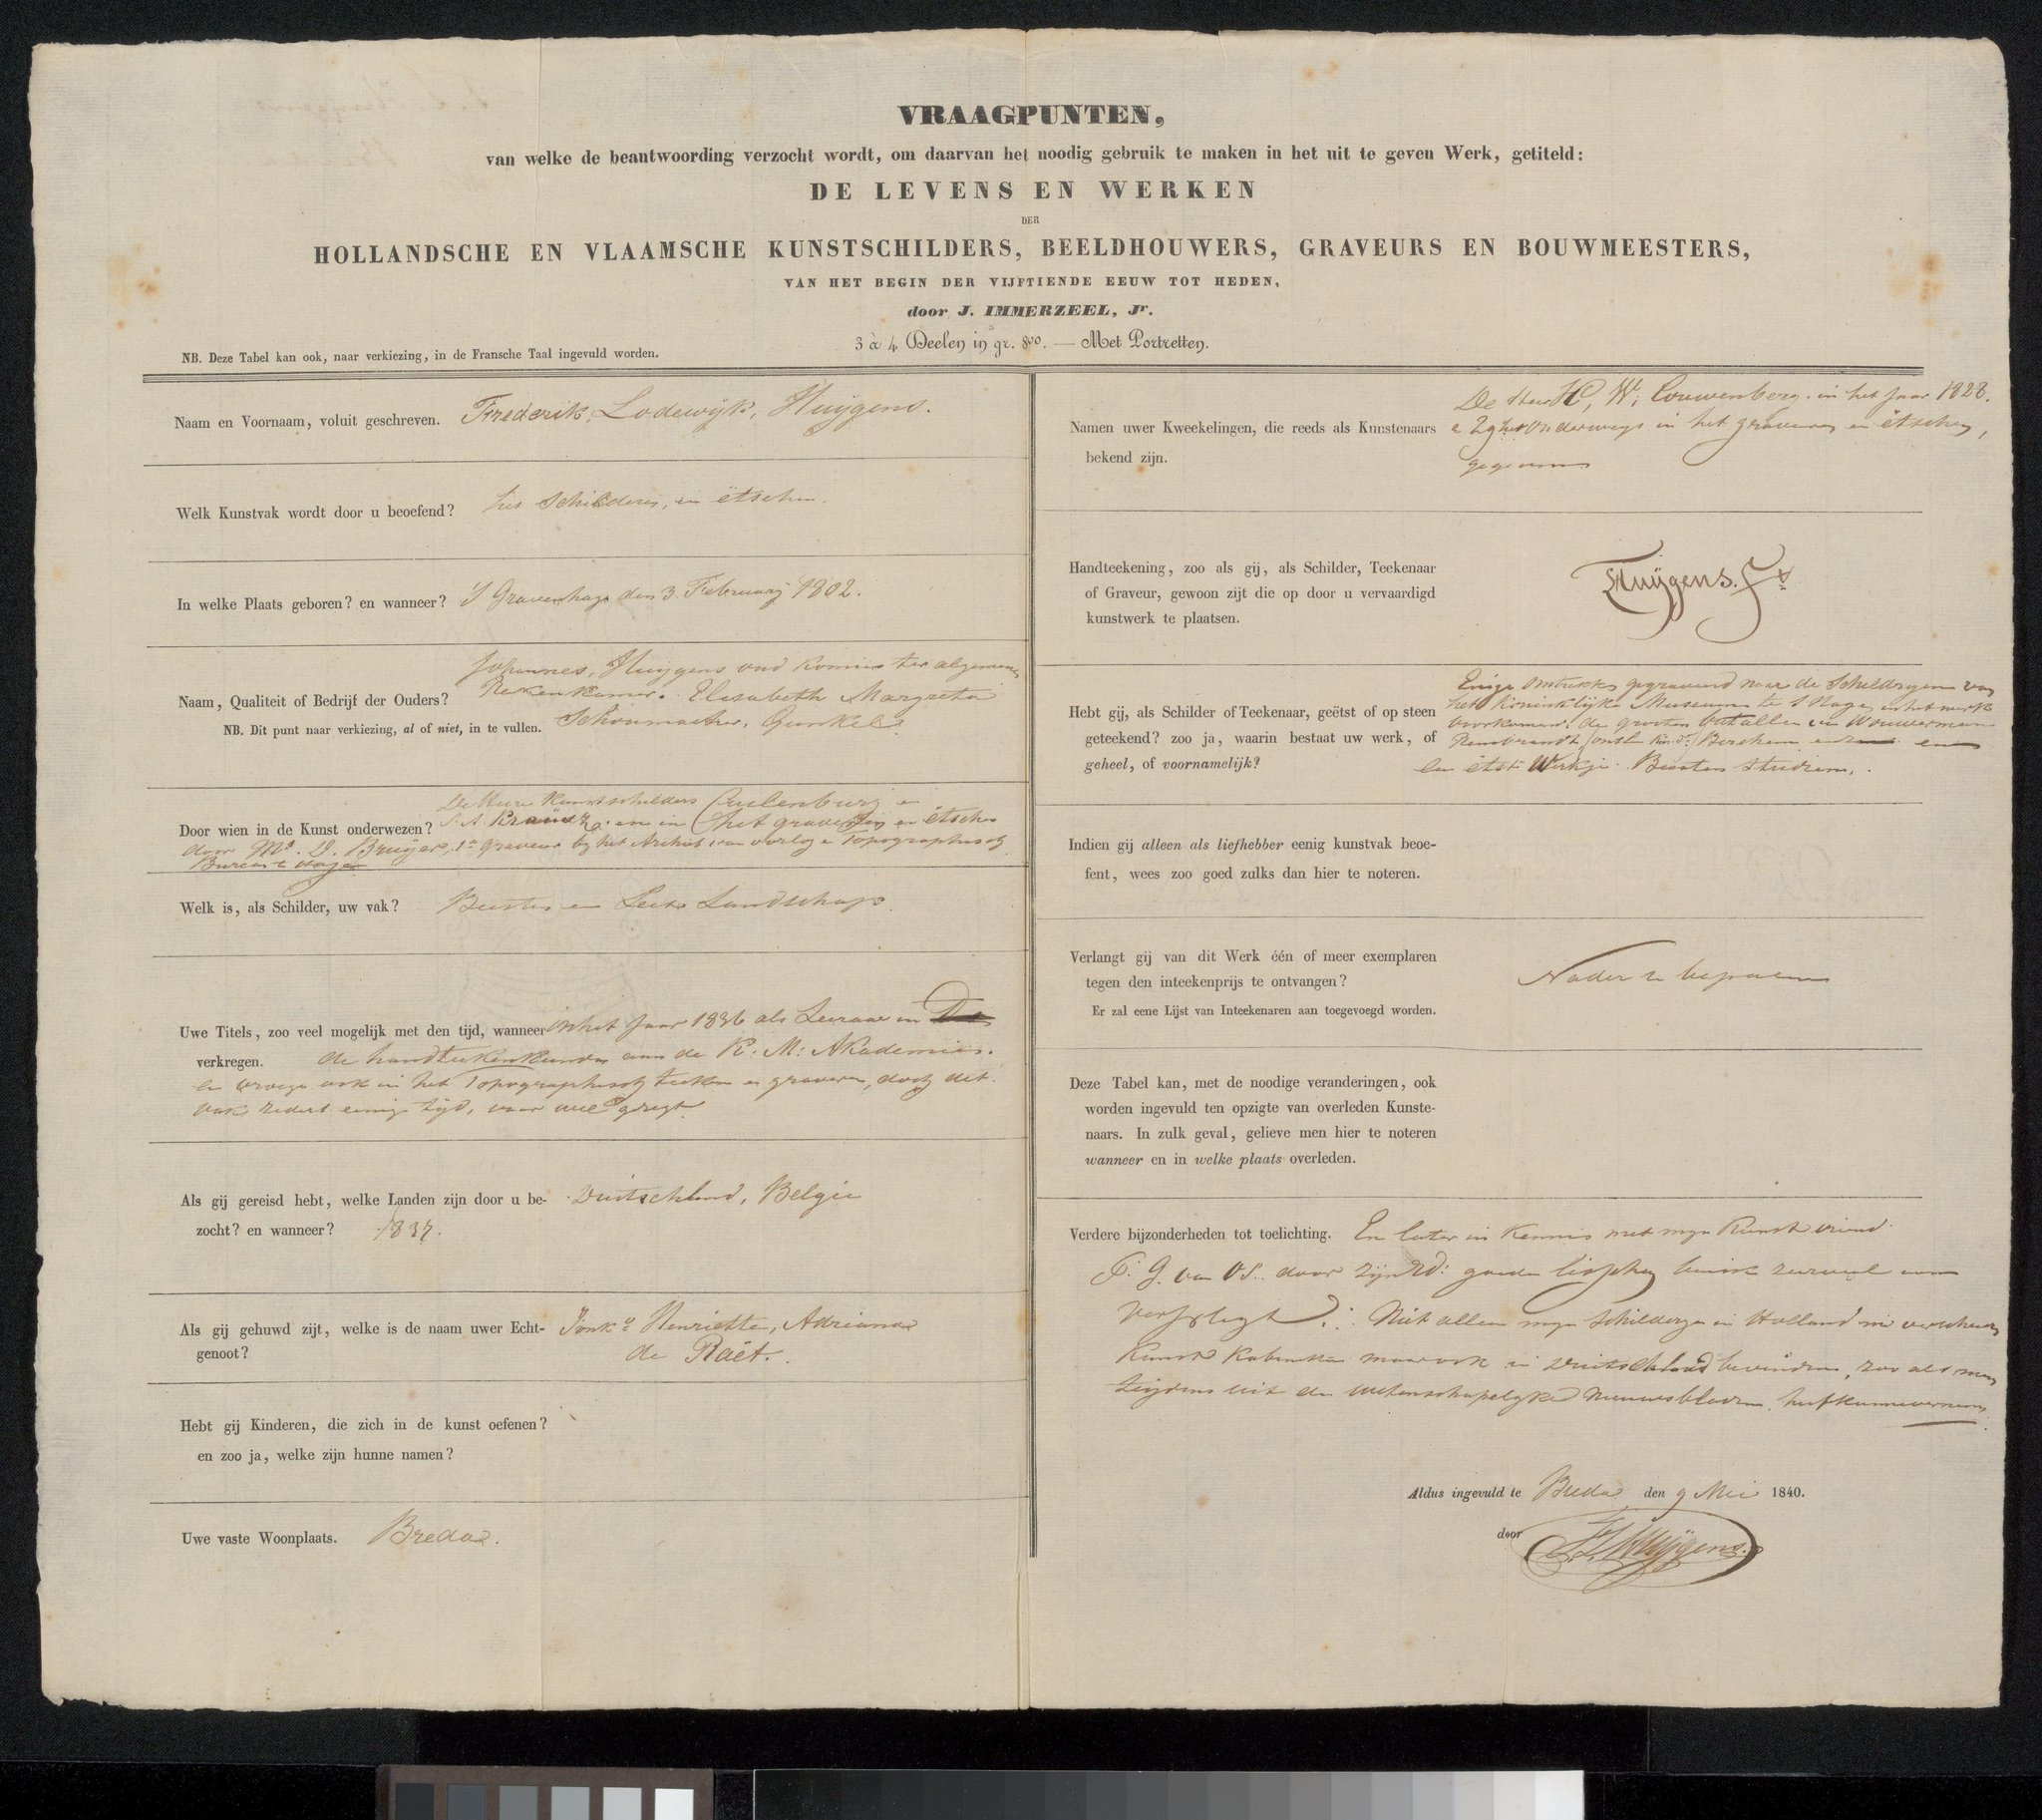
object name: manuscript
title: Enquêteformulier ingevuld door Frederik Lodewijk Huygens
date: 1840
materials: ink, paper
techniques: pen, printing, writing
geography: breda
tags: leiden, print maker, draughtsman, frederik lodewijk huygens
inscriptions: inscription: ‘Vraagpunten,/ van welke de beantwoording verzocht wordt, om daarvan het noodig gebruik te maken in het uit te geven Werk, getiteld: De levens en werken/ der Hollandsche en Vlaamsche kunstschilders, beeldhouwers,/ graveurs en bouwmeesters, van het begin der vijftiende eeuw tot heden/ door J. Immerzeel, Jr.’, watermark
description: Opgenomen in: Immerzeel, J. Jr., De levens en werken der Hollandsche en Vlaamsche kunstschilders, beeldhouwers, graveurs en bouwmeesters, van het begin der vijftiende eeuw tot heden, Amsterdam: J.C. van Kesteren, 1842-1843.